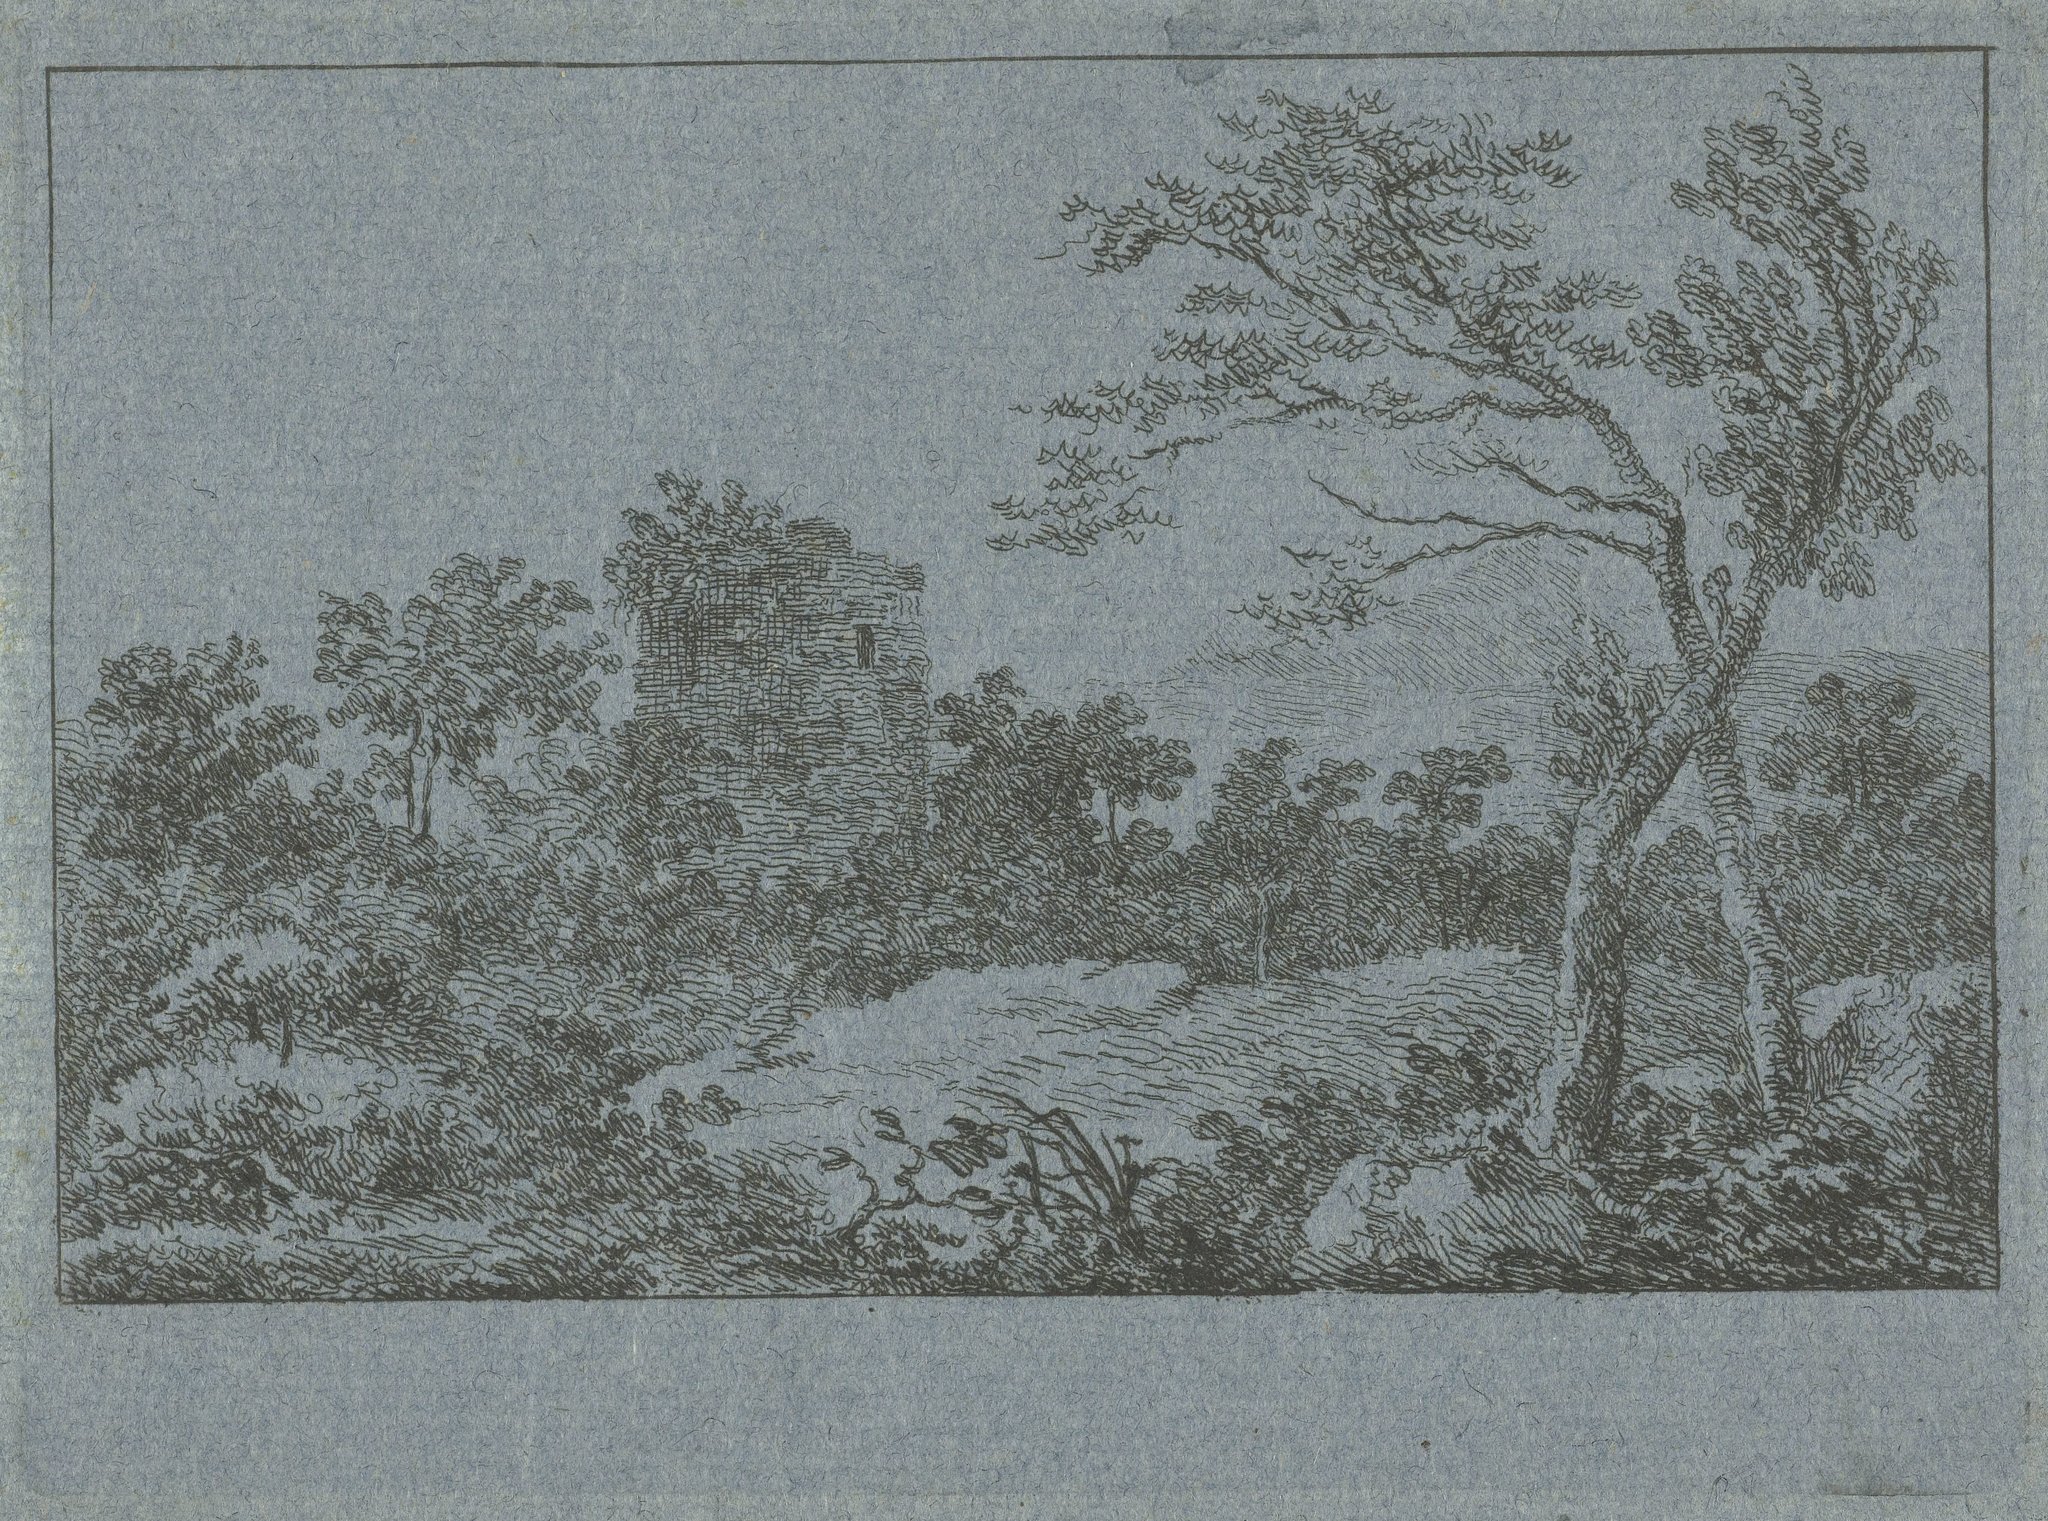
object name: print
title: Landschap met ruïne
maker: gerardus emaus de micault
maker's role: draughtsman, print maker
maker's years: 1798-1863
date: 1813-1863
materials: paper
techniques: etching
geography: netherlands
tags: landscape with ruins